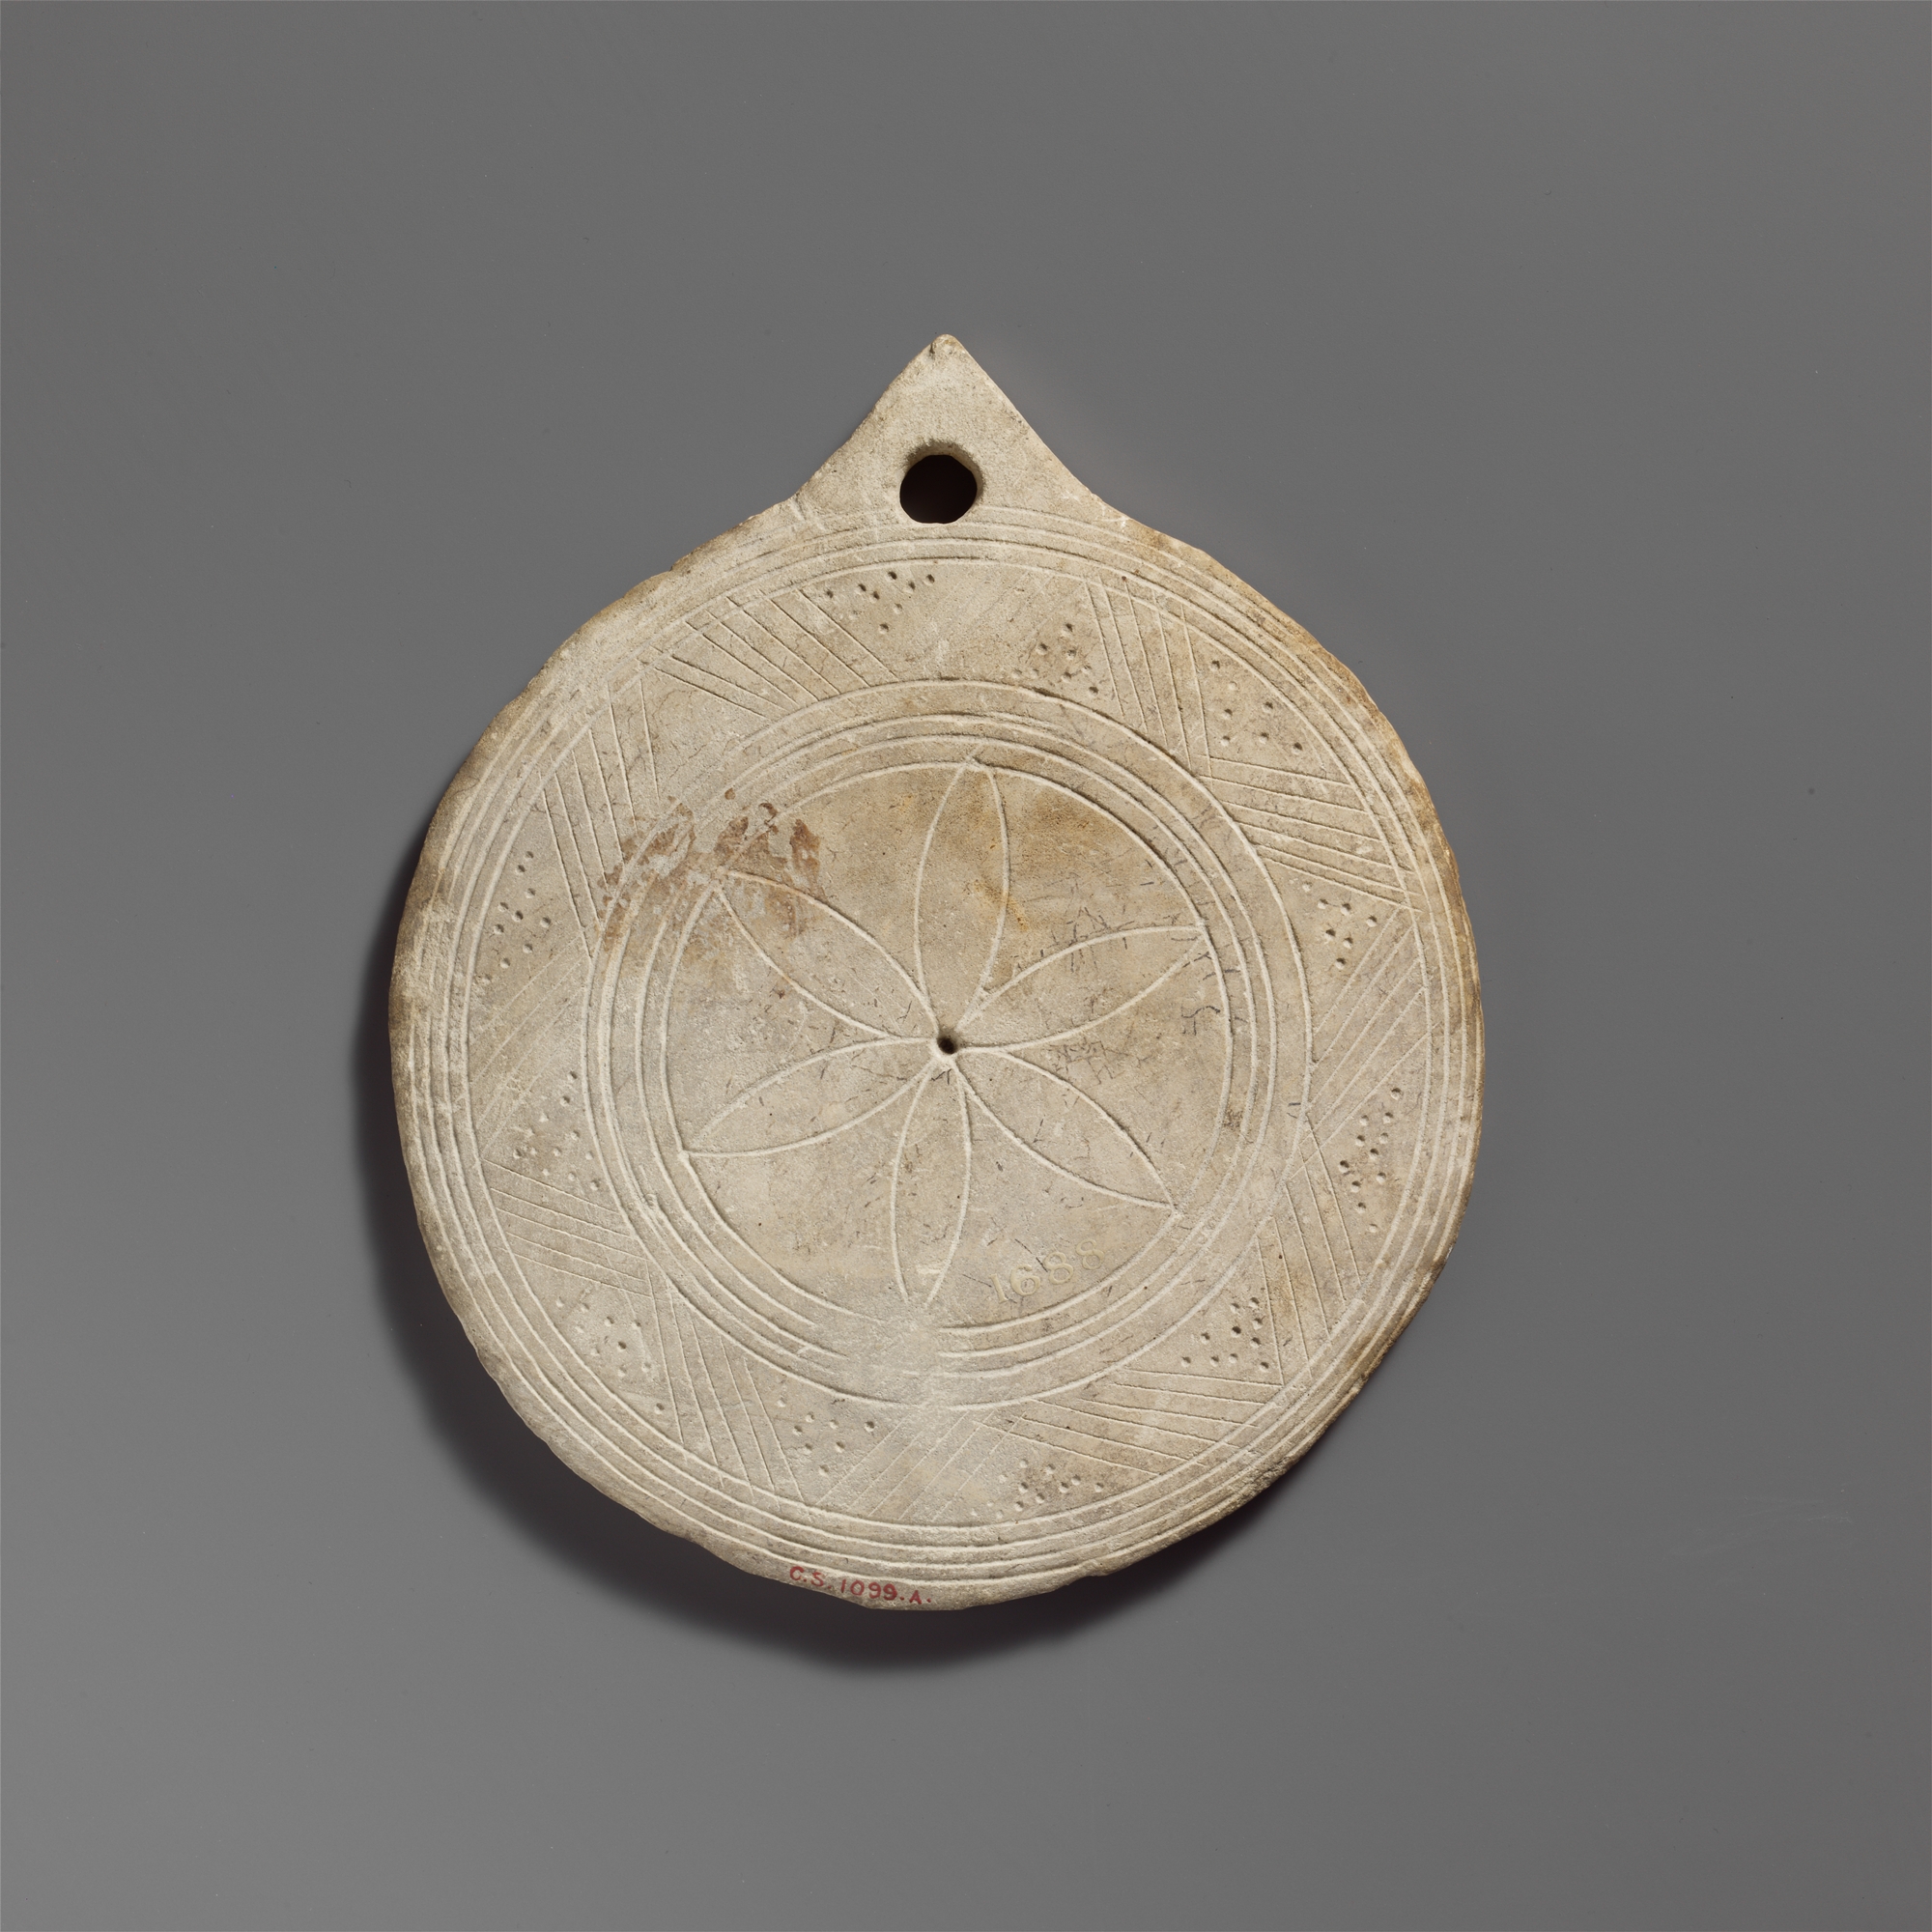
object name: disk, votive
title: Limestone disk with geometric decoration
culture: cypriot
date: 3900 BCE-100 CE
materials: limestone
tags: flowers